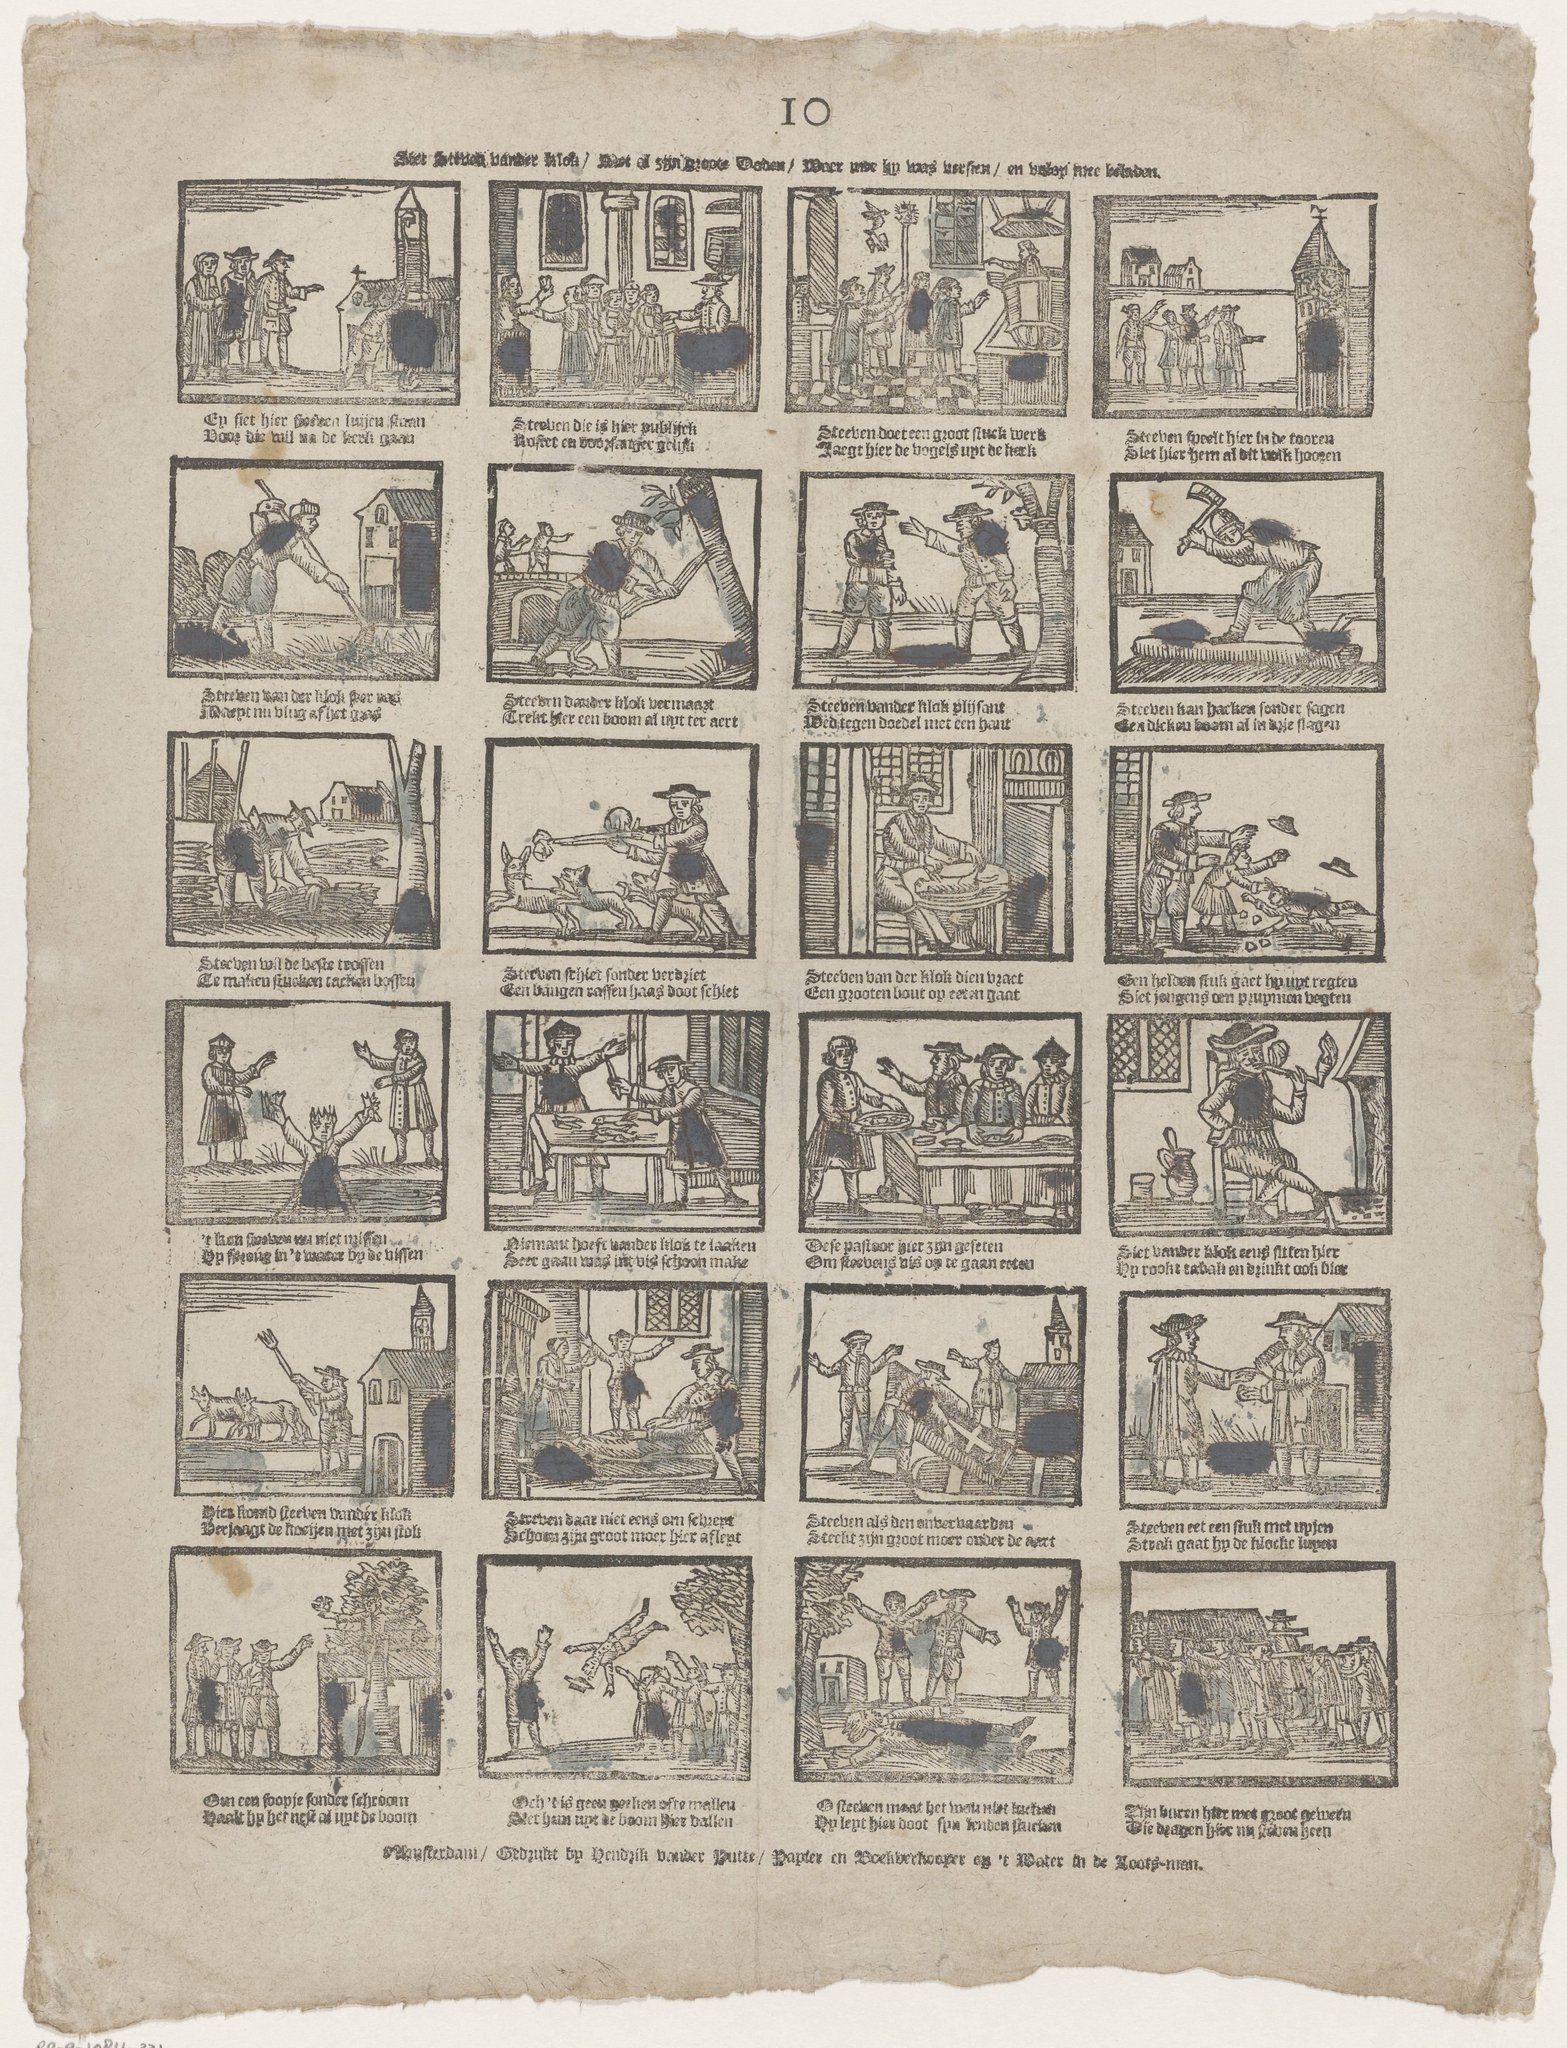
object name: print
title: Siet Steven van der Klok / Met al zijn groote sasen / Waer mee hy was versien / en volop mee beladen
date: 1761-1765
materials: paper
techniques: colour, letterpress printing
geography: netherlands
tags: death by accident (non-violent death), funerary ceremonial, tales and fairy tales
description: Blad met 24 voorstellingen over het leven van Steven van der Klok. Onder elke afbeelding een tweeregelig vers. Genummerd midden boven: 10.